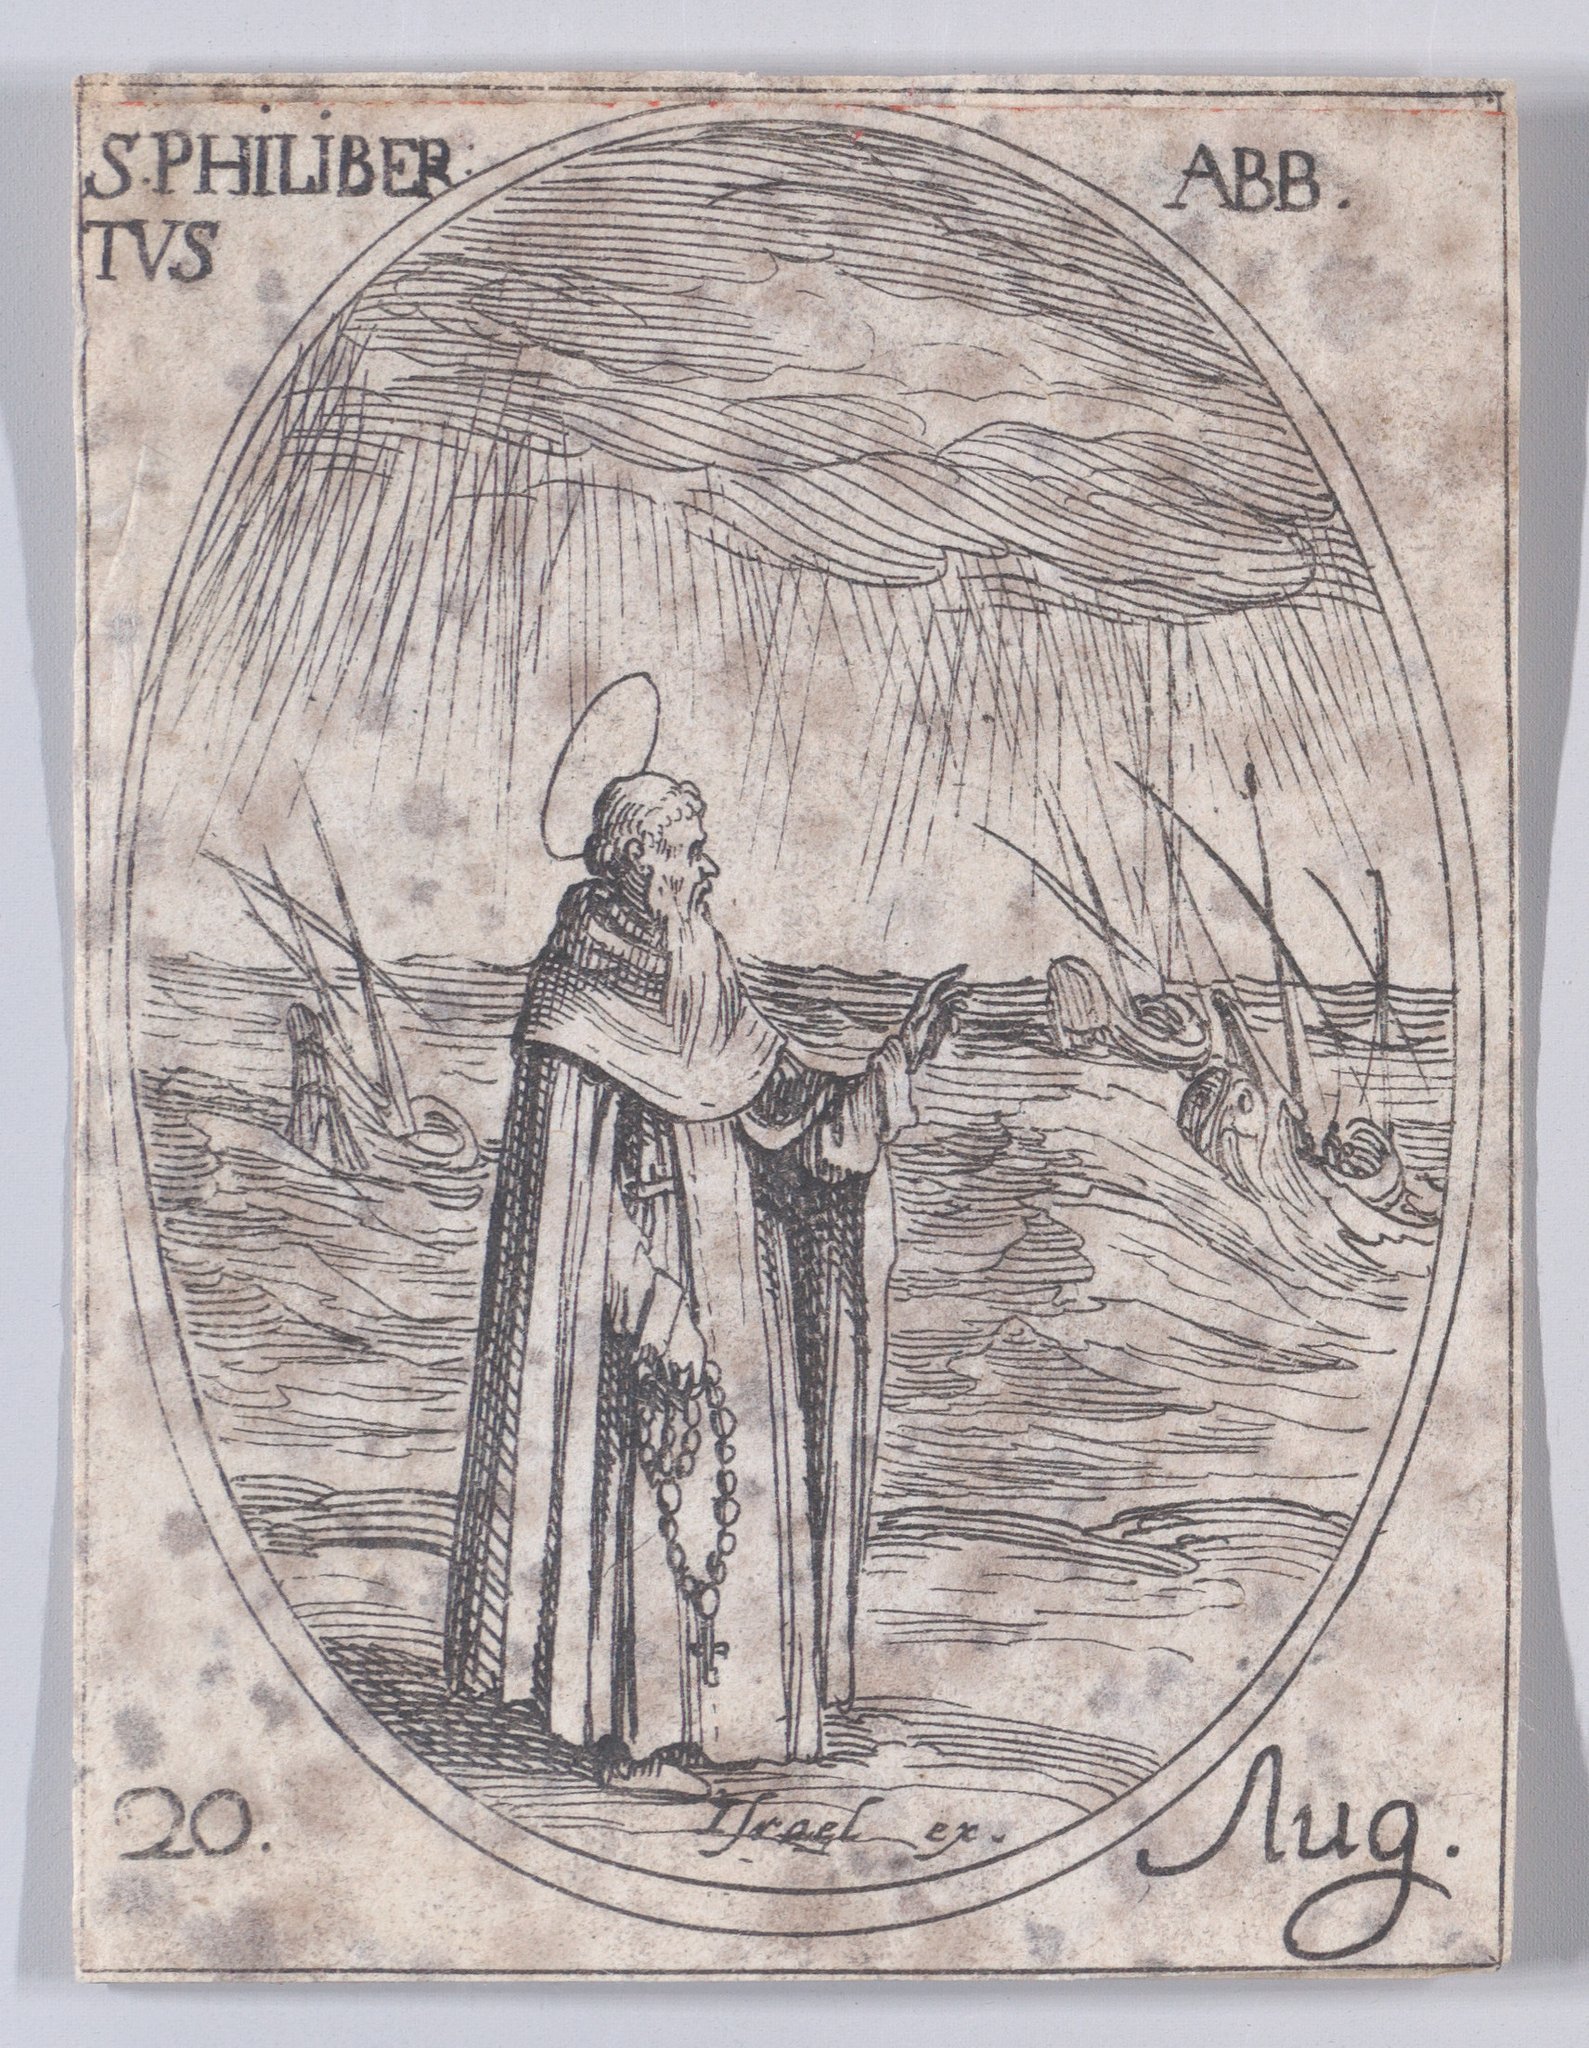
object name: print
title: S. Philibert, abbé (St. Philibert, Abbot), August 20th, from "Les Images De Tous Les Saincts et Saintes de L'Année" (Images of All of the Saints and Religious Events of the Year)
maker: jacques callot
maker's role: artist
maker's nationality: french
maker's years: 1592-1635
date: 1636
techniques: etching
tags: men,saints